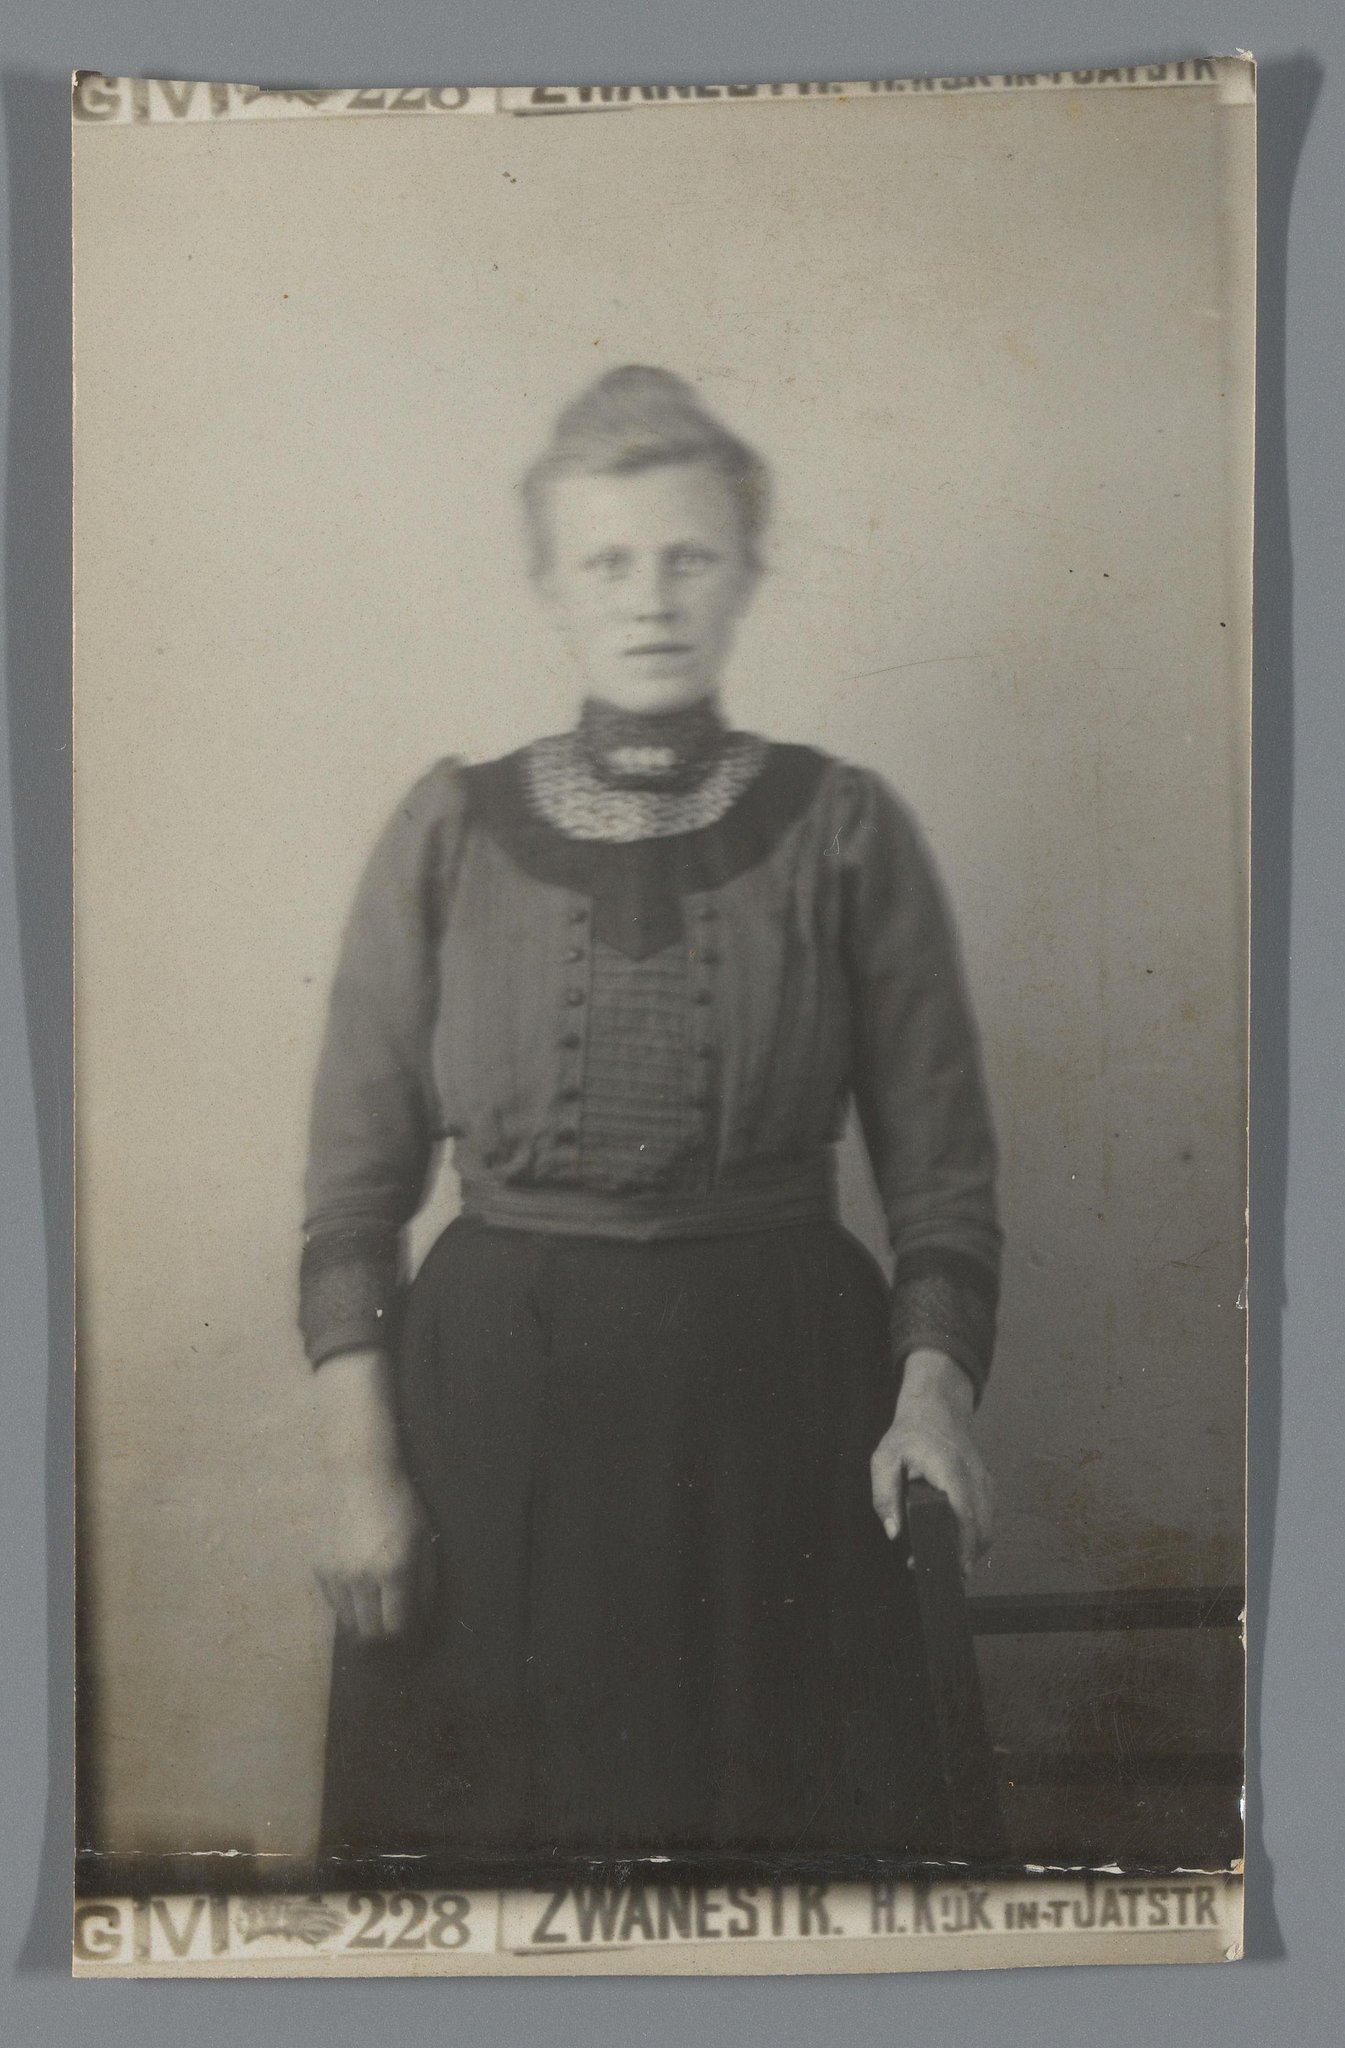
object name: snapshot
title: Portret van een vrouw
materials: photographic support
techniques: gelatin silver print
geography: groningen